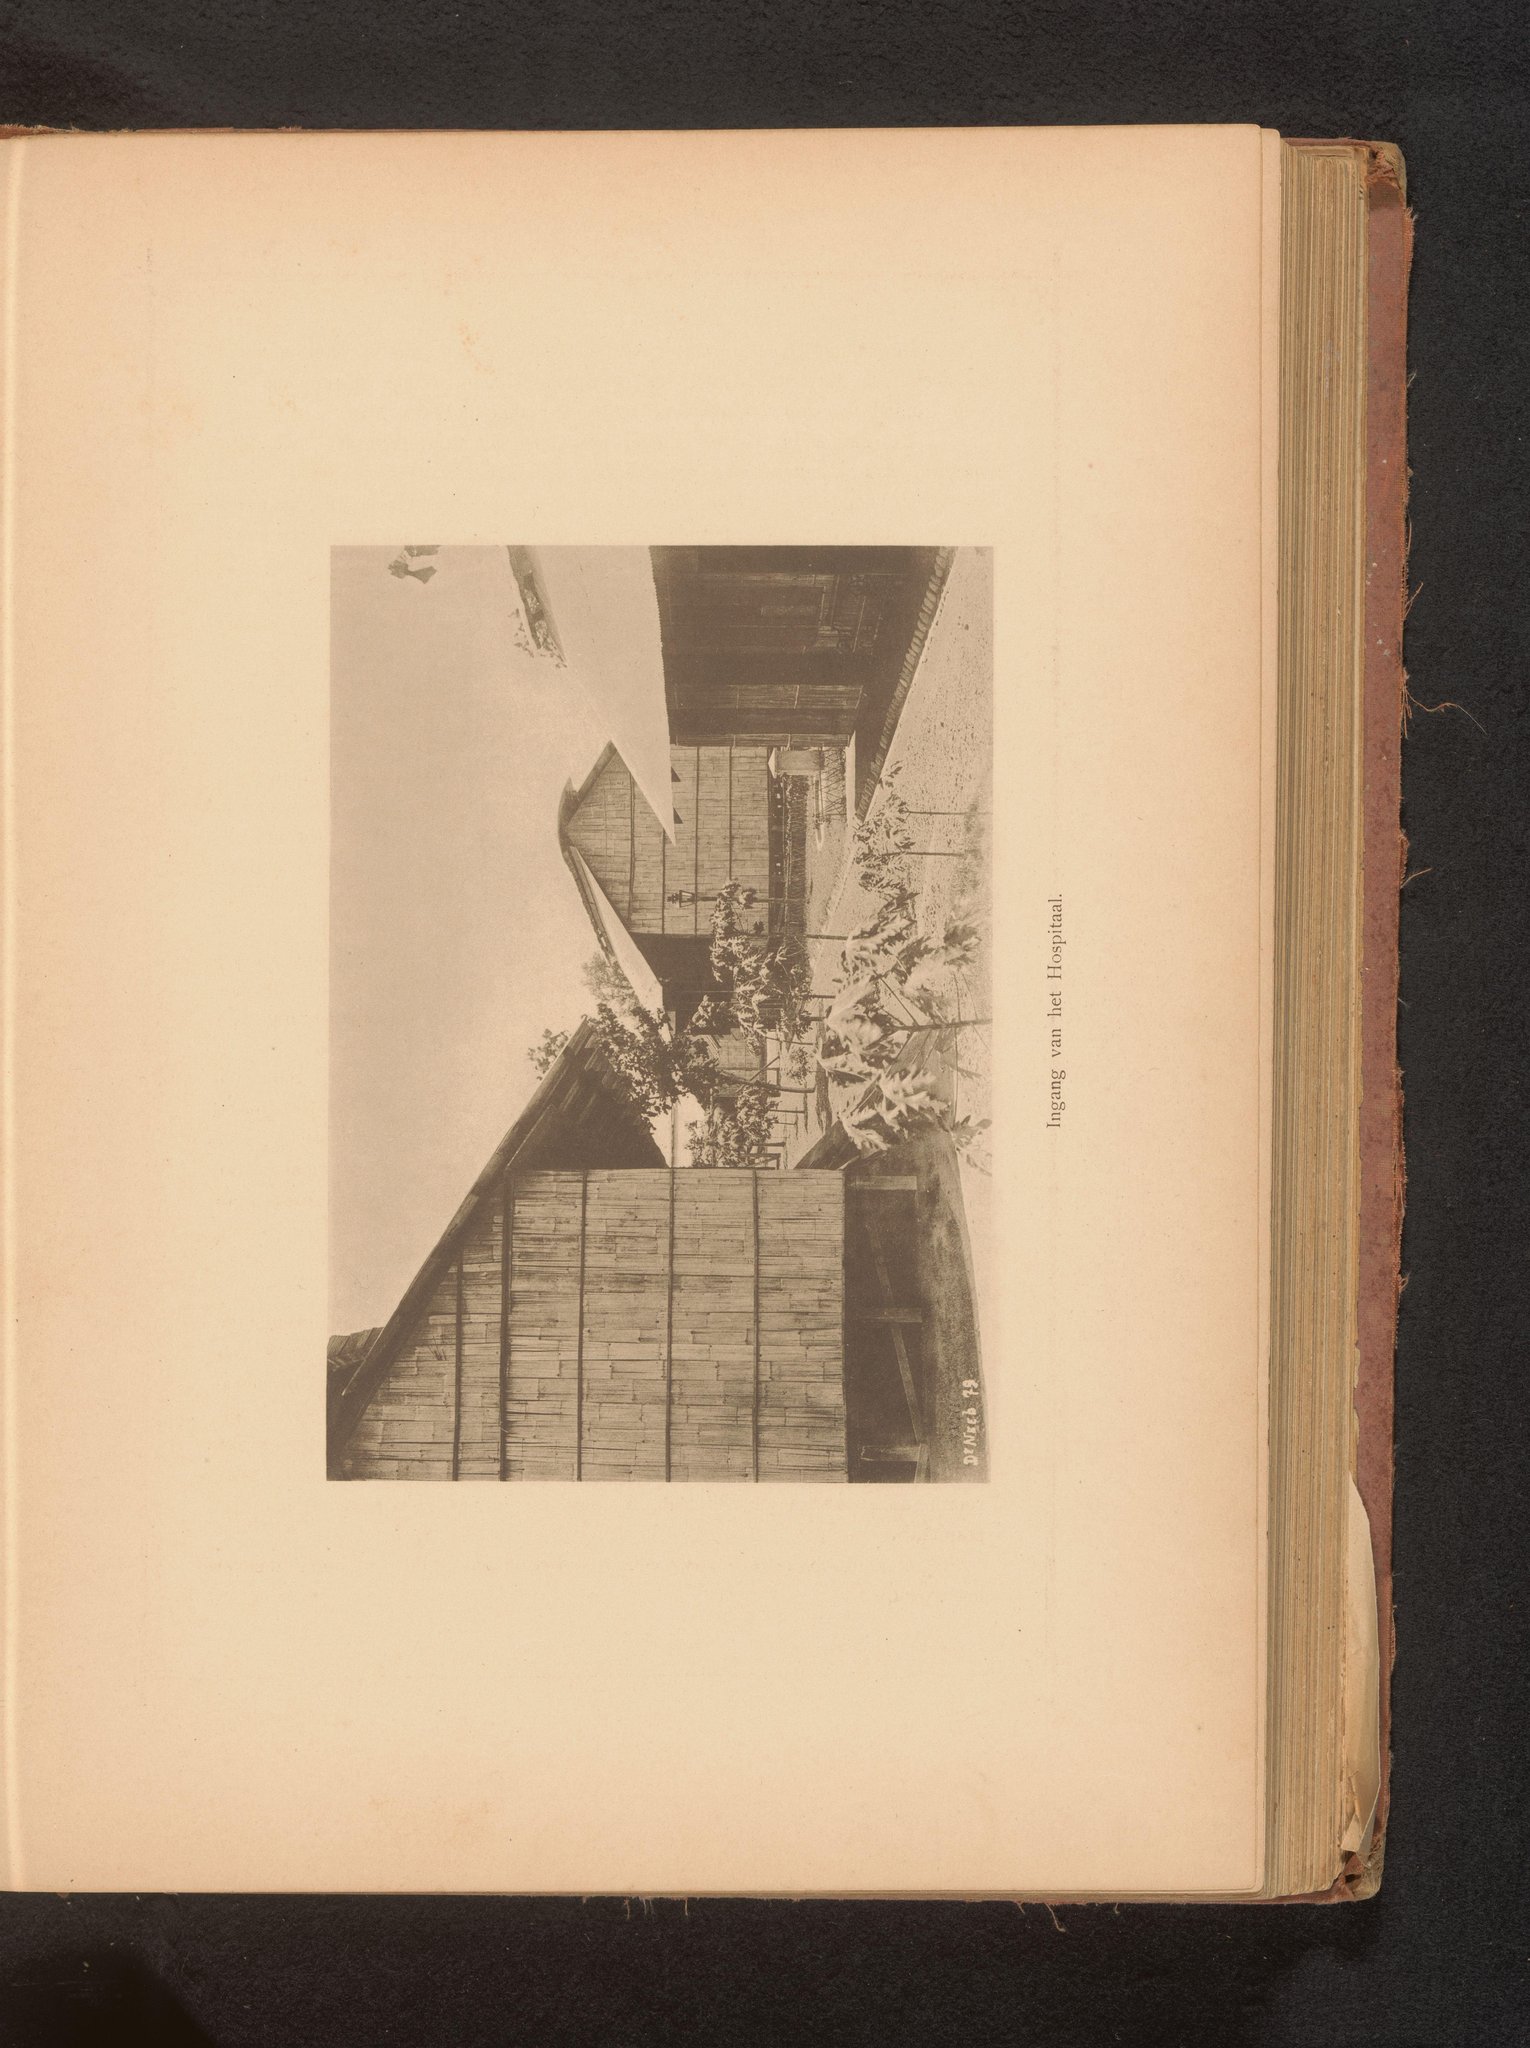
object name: photomechanical print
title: Gezicht op de ingang van een ziekenhuis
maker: christiaan johan neeb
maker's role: arts, fotograaf, officier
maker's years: 1860-1925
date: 1892-1897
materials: paper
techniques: photograph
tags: gate, entrance, hospital